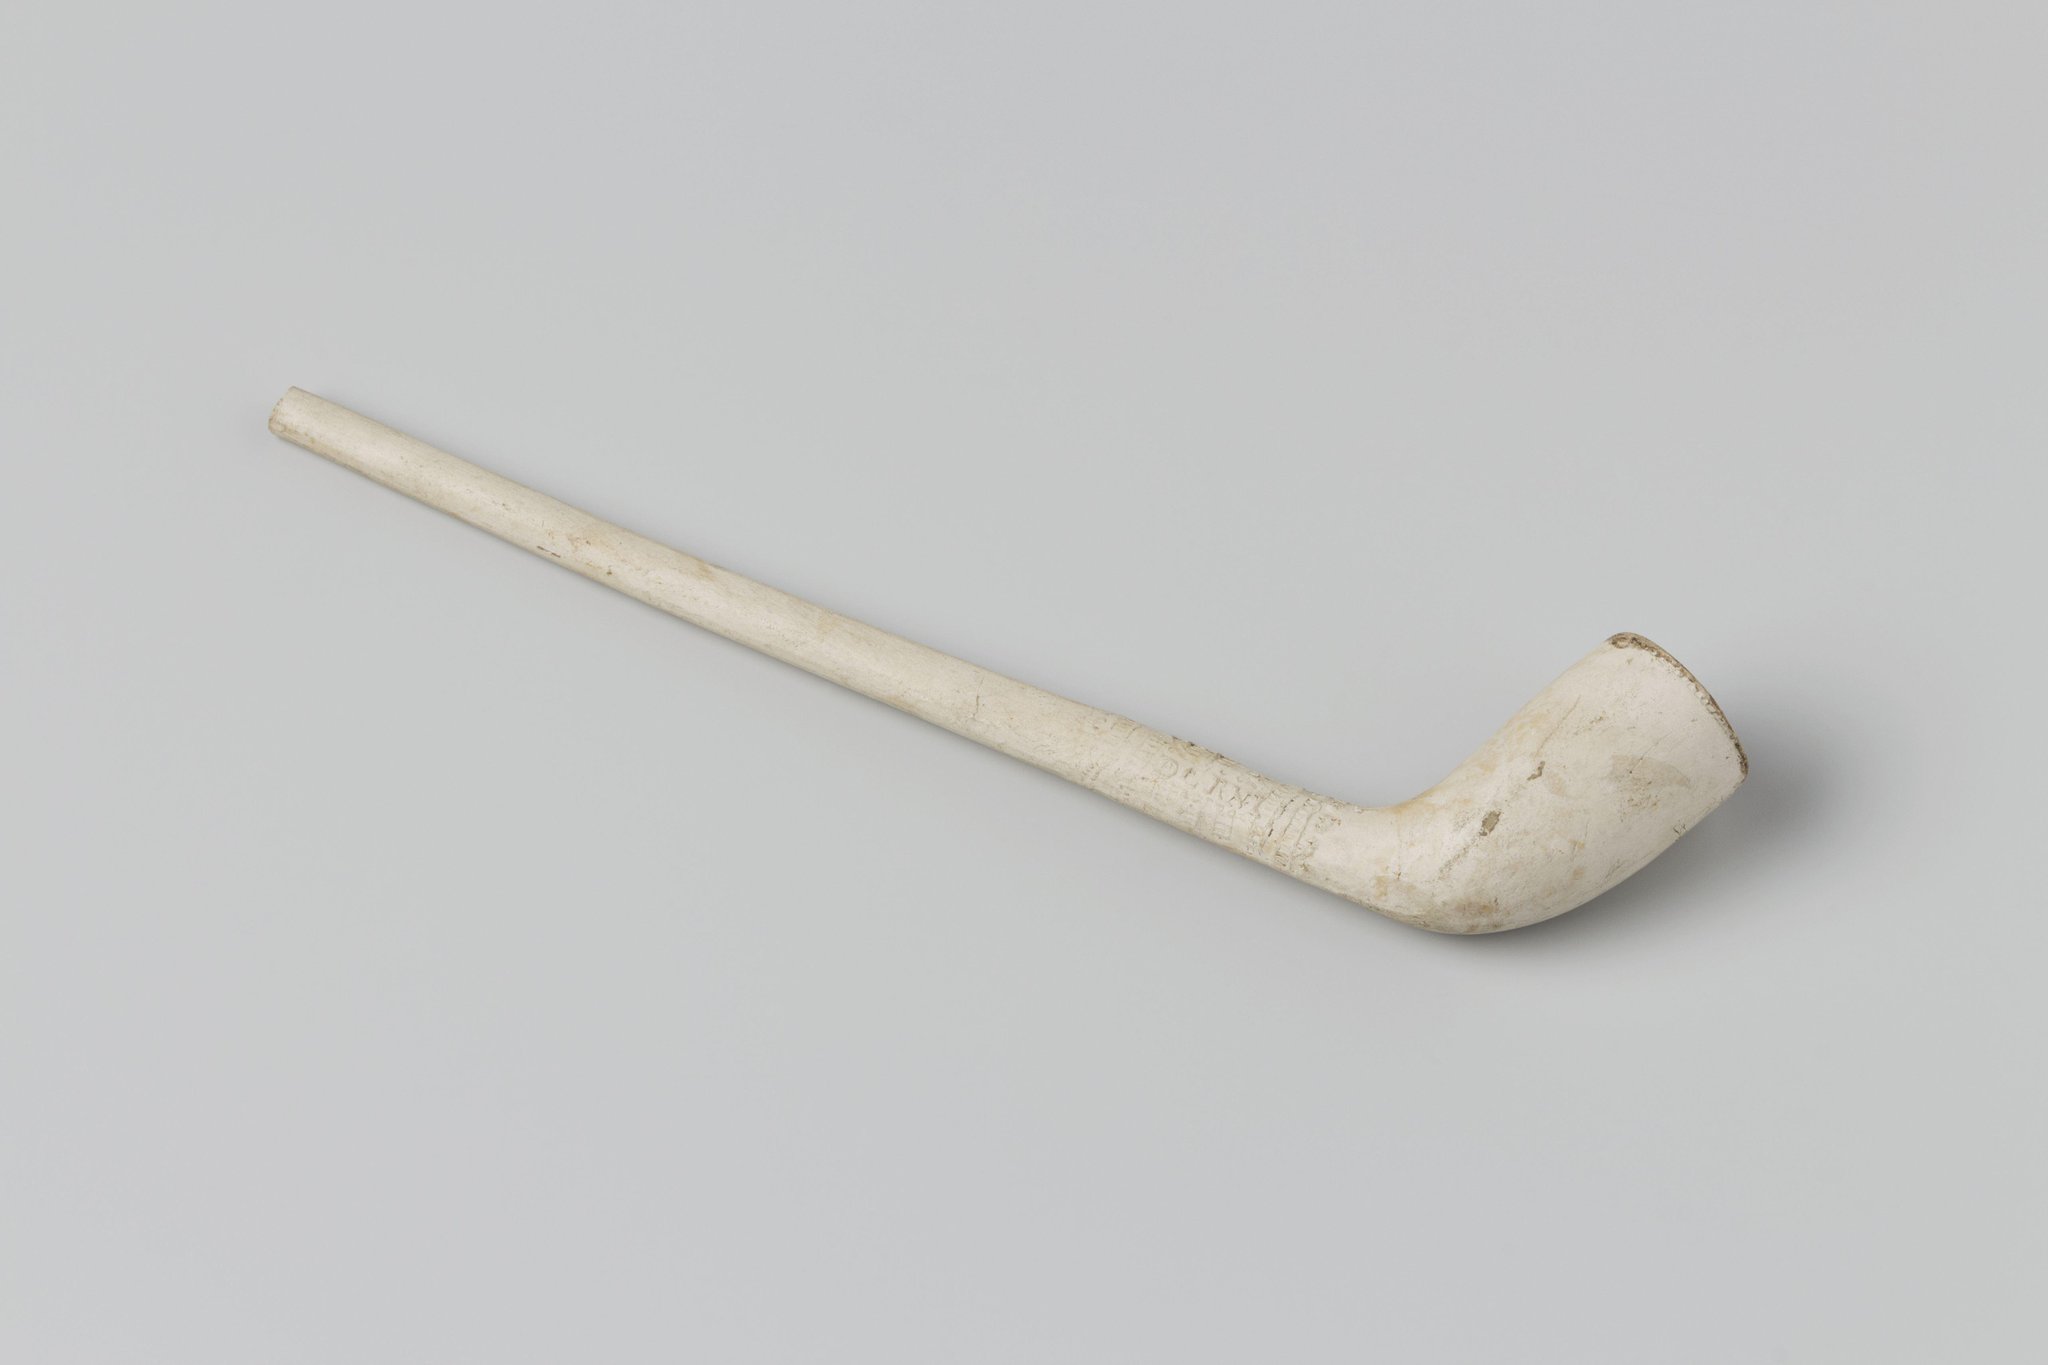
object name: tabakspijp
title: Tabakspijp, waarop PETER DORNI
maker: Anonymous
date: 1400-1950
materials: clay